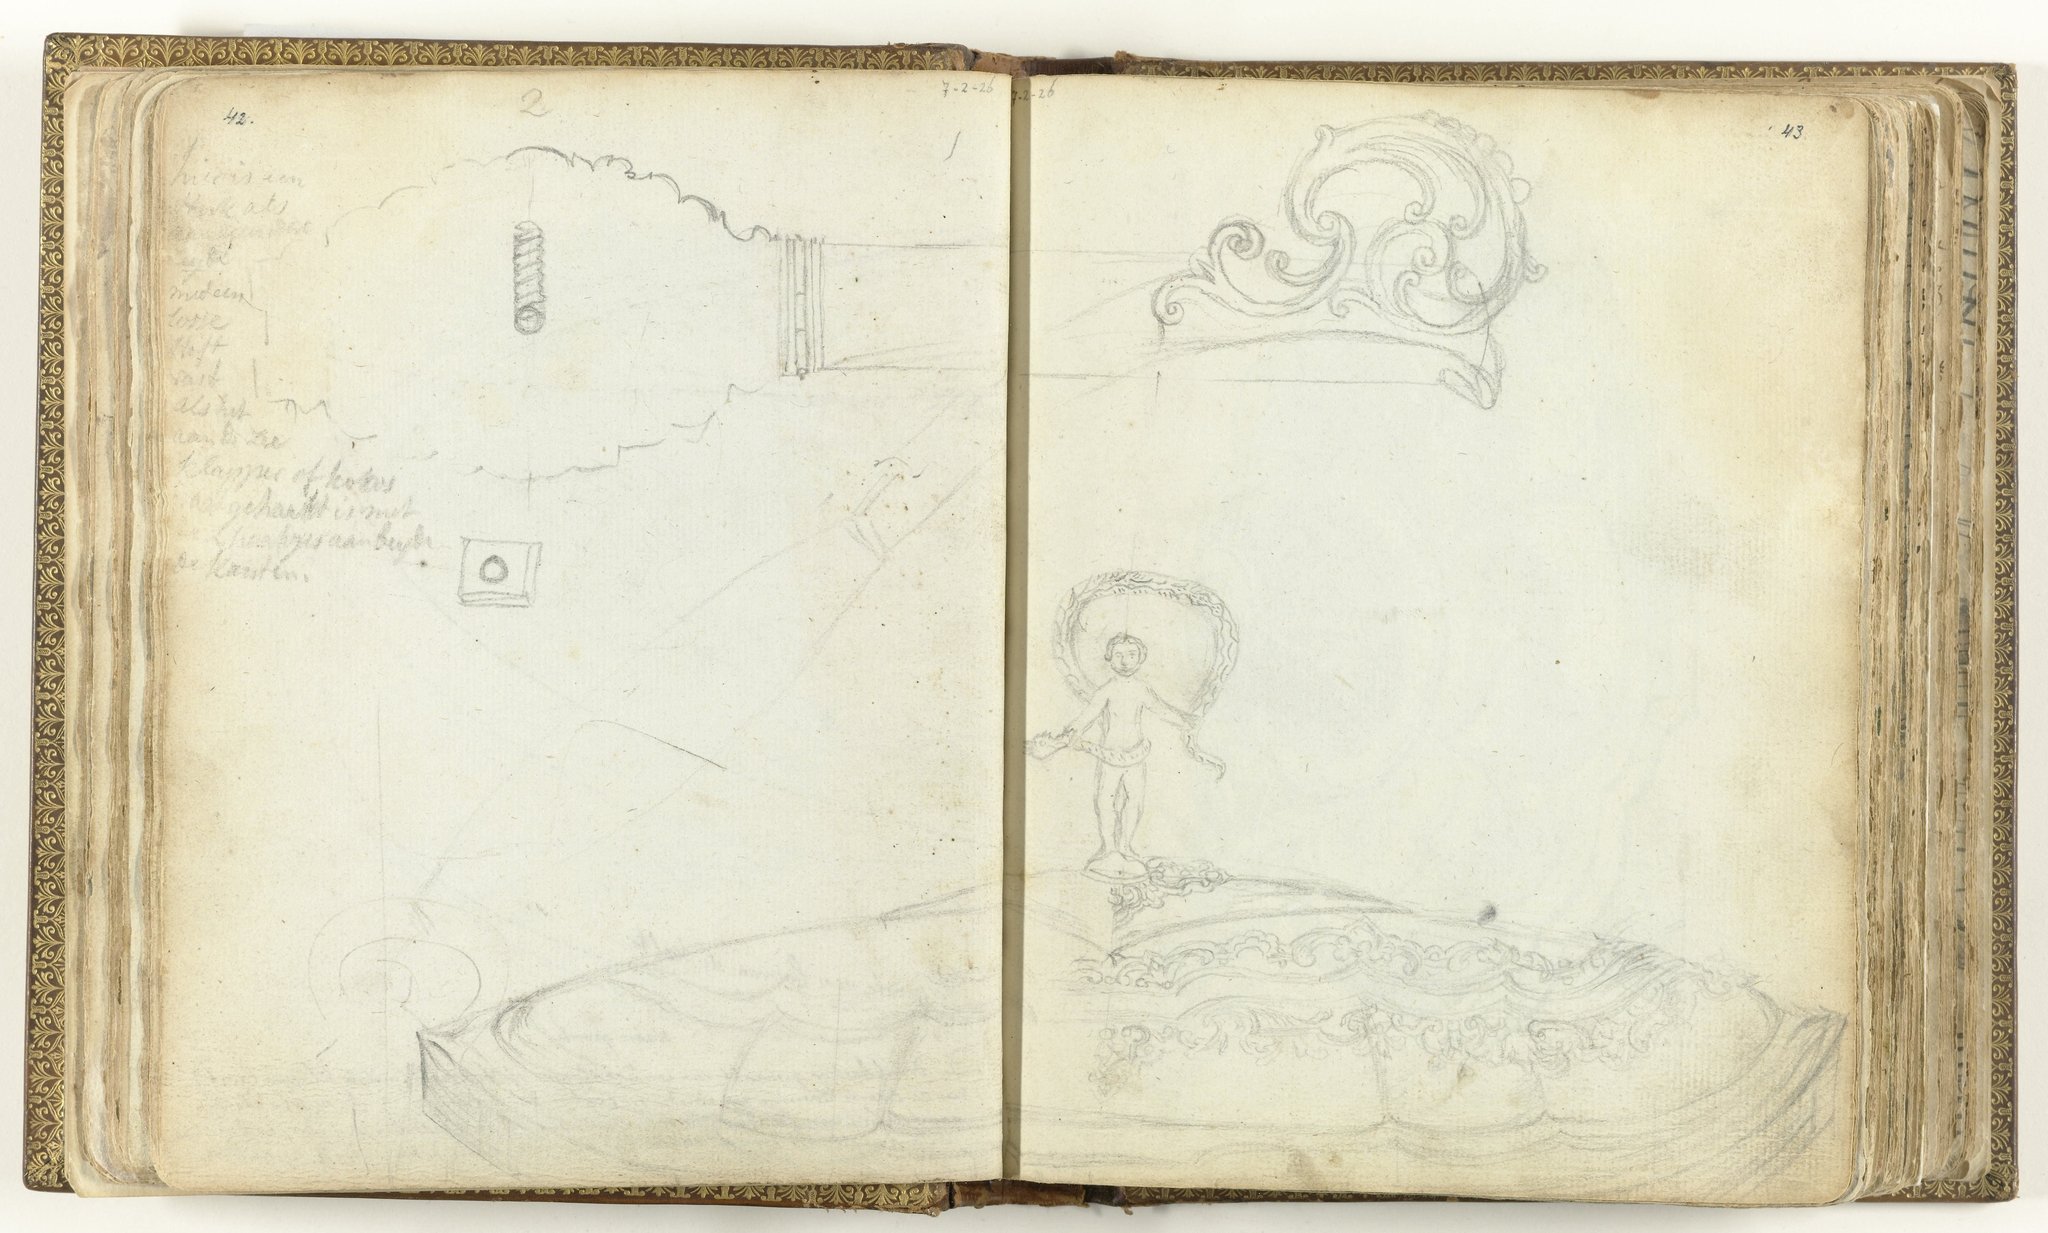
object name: drawing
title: Details en versieringen van drinkvat van koning van Kandy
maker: jan brandes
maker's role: draughtsman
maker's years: 1743-1808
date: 1786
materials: paper, pencil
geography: indian ocean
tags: drinking-vessels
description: Potloodschets van de deksel, handvaten en bevestiging aan de zeeklapper. Met opschrift. Onderdeel uit het schetsboek van Jan Brandes, dl. 2 (1808), p. 42-43 en zie p. 39-41, 44.